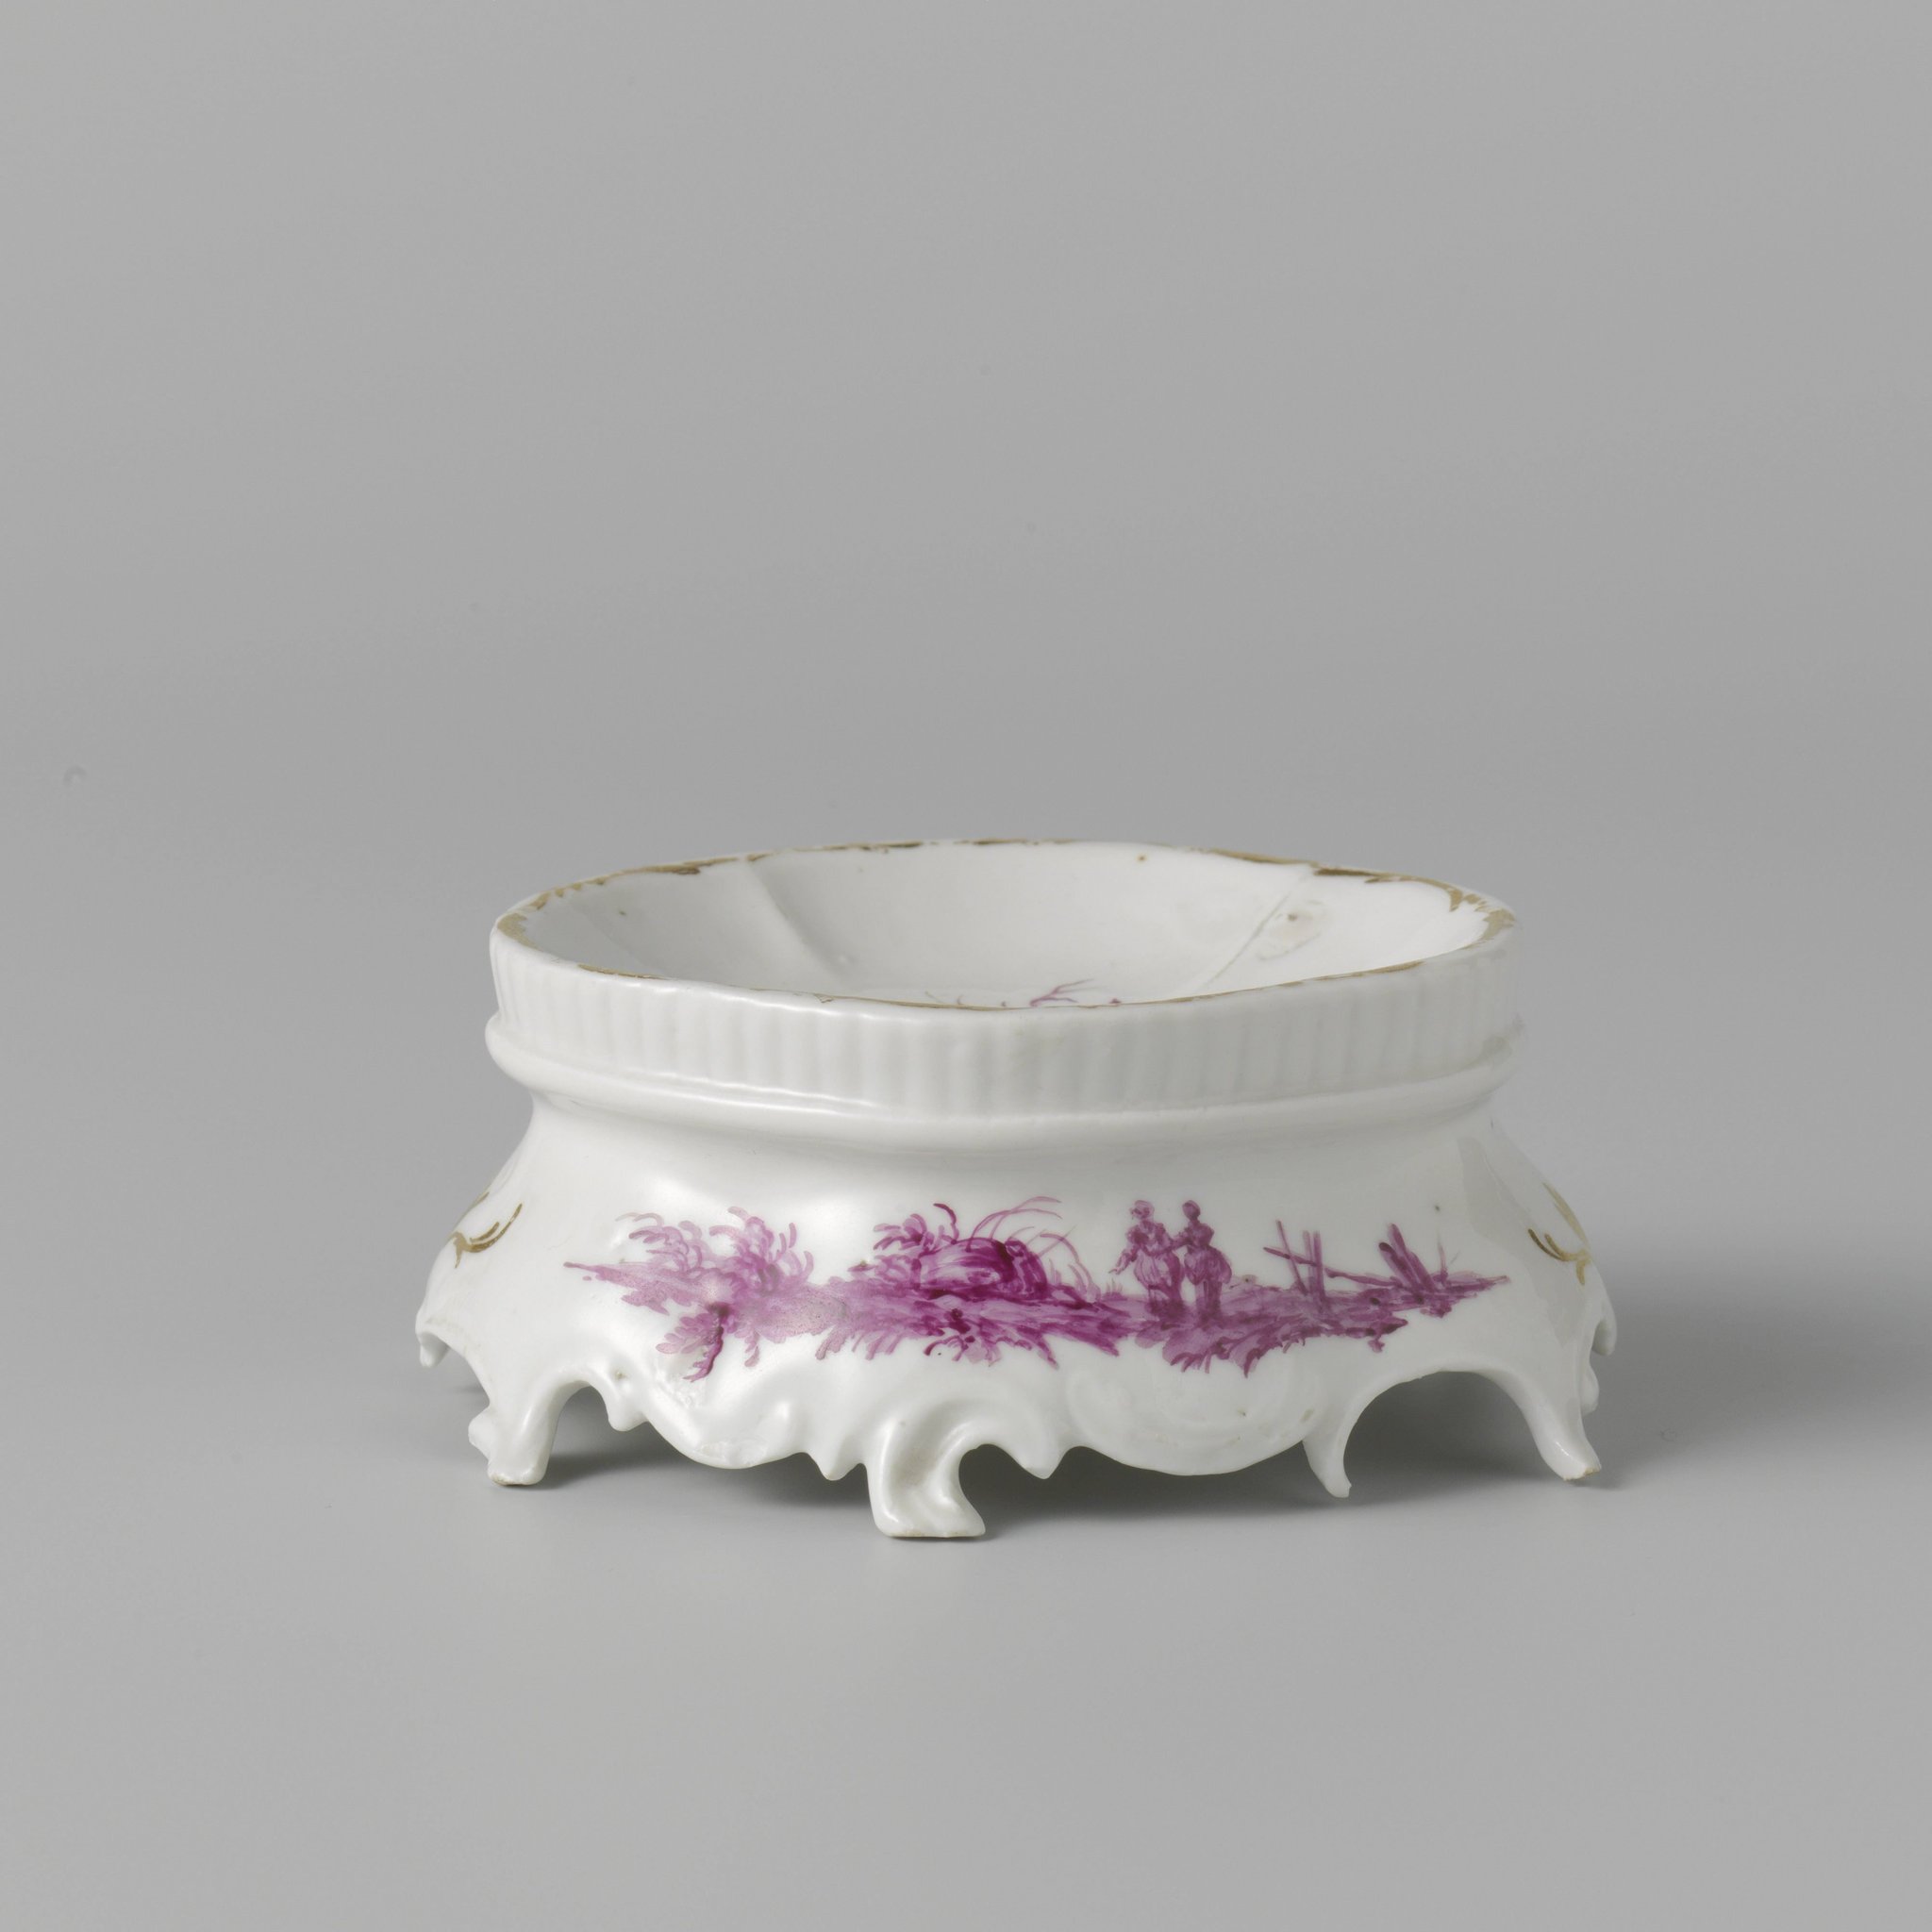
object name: salt condiment vessel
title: Two salt cellars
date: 1774-1778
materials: porcelain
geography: loosdrecht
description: Manufactuur Oud-Loosdrecht Loosdrecht, c. 1774–1778 hard-paste porcelain